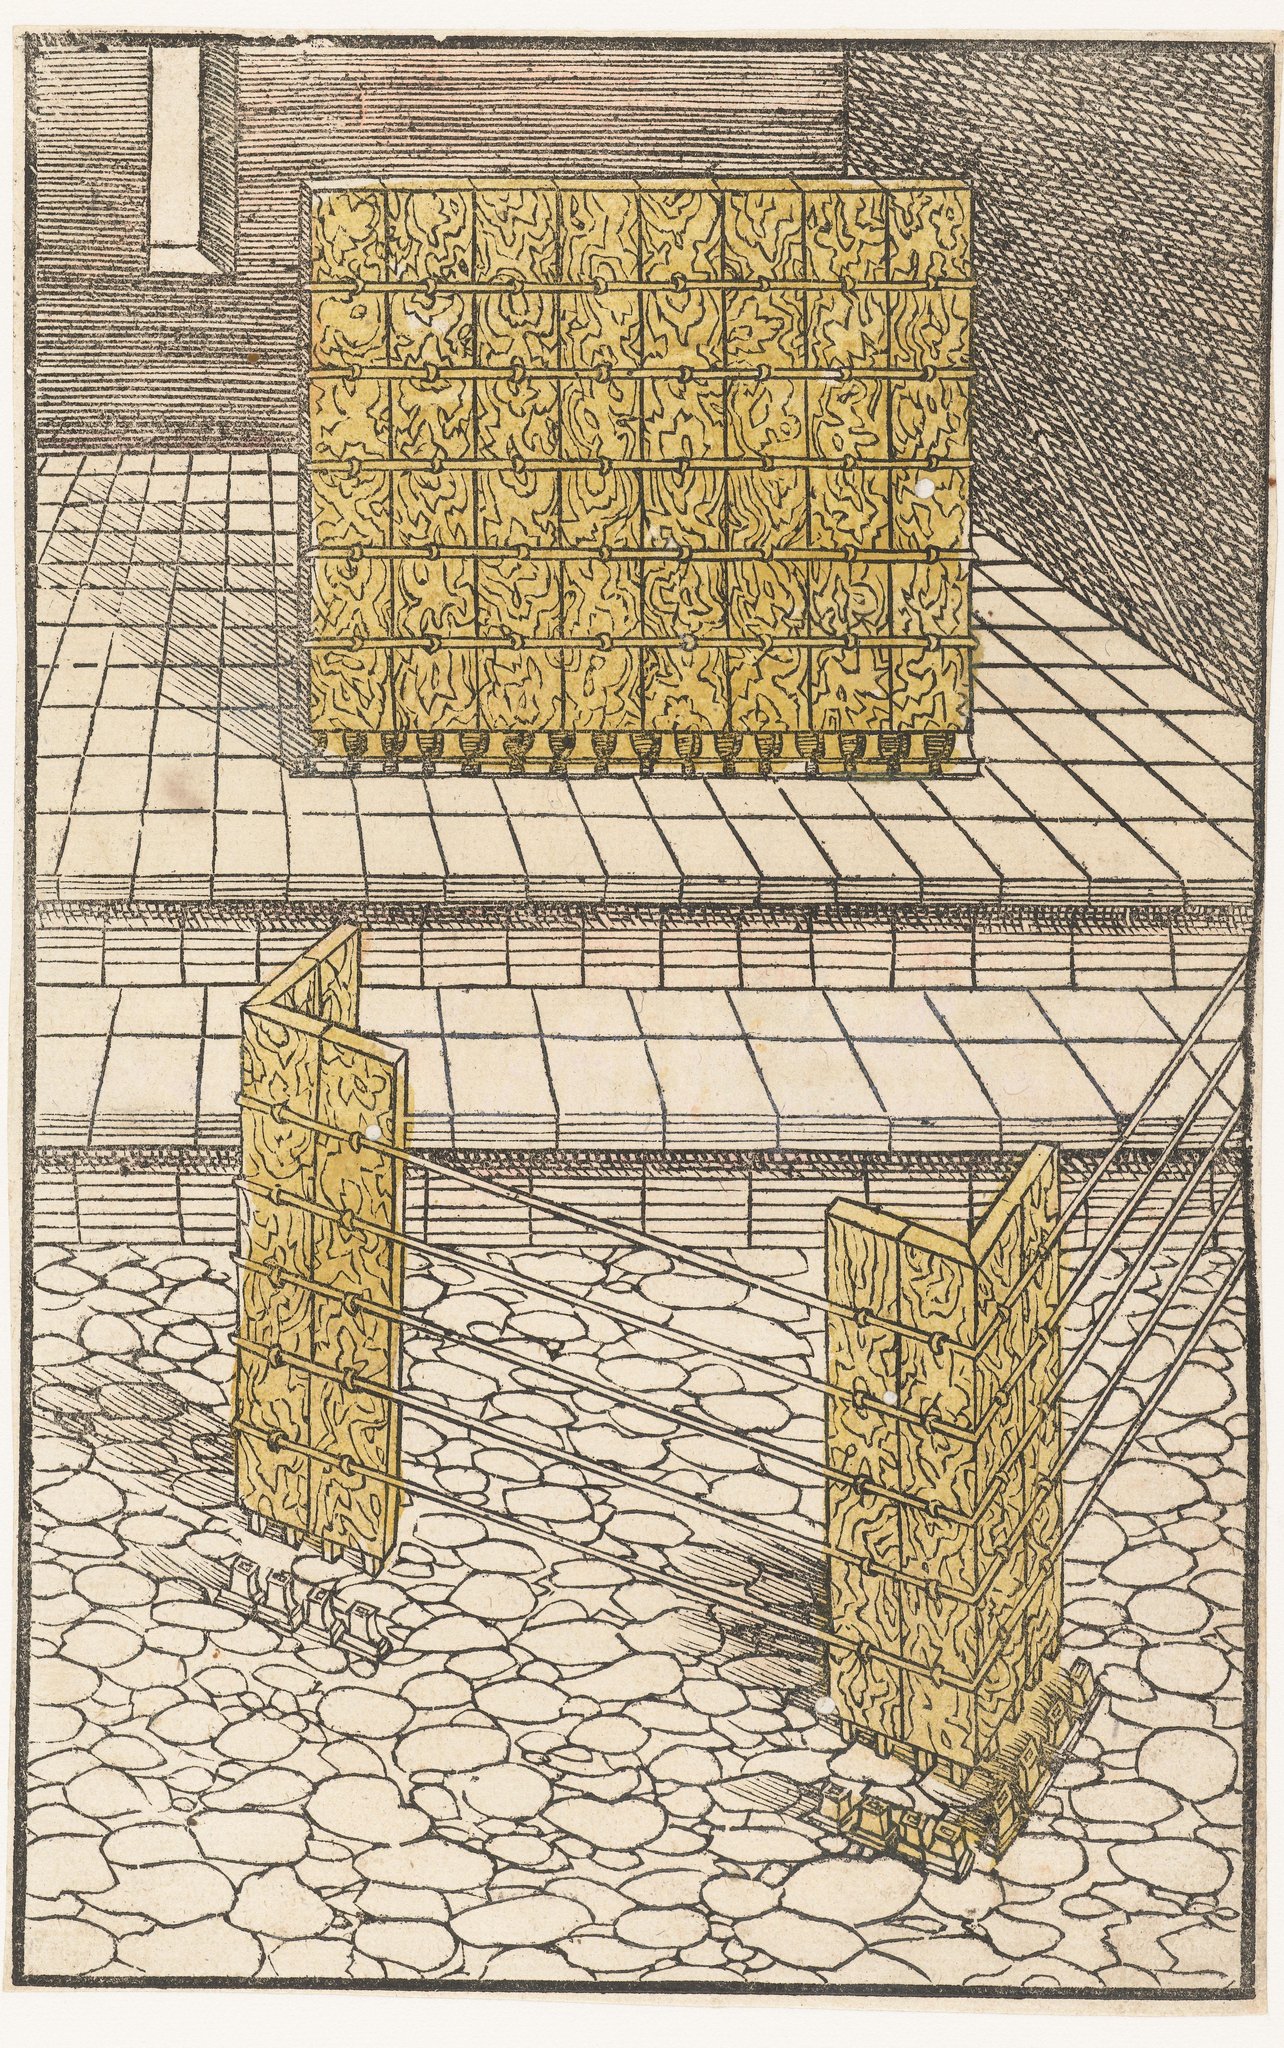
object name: book illustration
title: Onderdelen van het tabernakel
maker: lucas cranach (i)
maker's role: draughtsman, print maker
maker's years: 1472-1553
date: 1523-1526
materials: paper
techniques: hand coloring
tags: tabernacle, 'mishkan' ~ jewish religion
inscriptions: collector's mark: Lugt 2233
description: Houtblokken gebruikt voor: Das Alte Testament deutsch, deel I, Wittenberg 1523 (eerste druk) maar ook later (tot 1526) verschenen drukken waarin de houtblokken werden gebruikt. De serie van elf boekillustraties in de collectie van het RMA heeft blanco verso zijden, dit is kenmerkend voor deze uitgaven van Luthers bijbel, zie Koepplin 1974, p. 341.